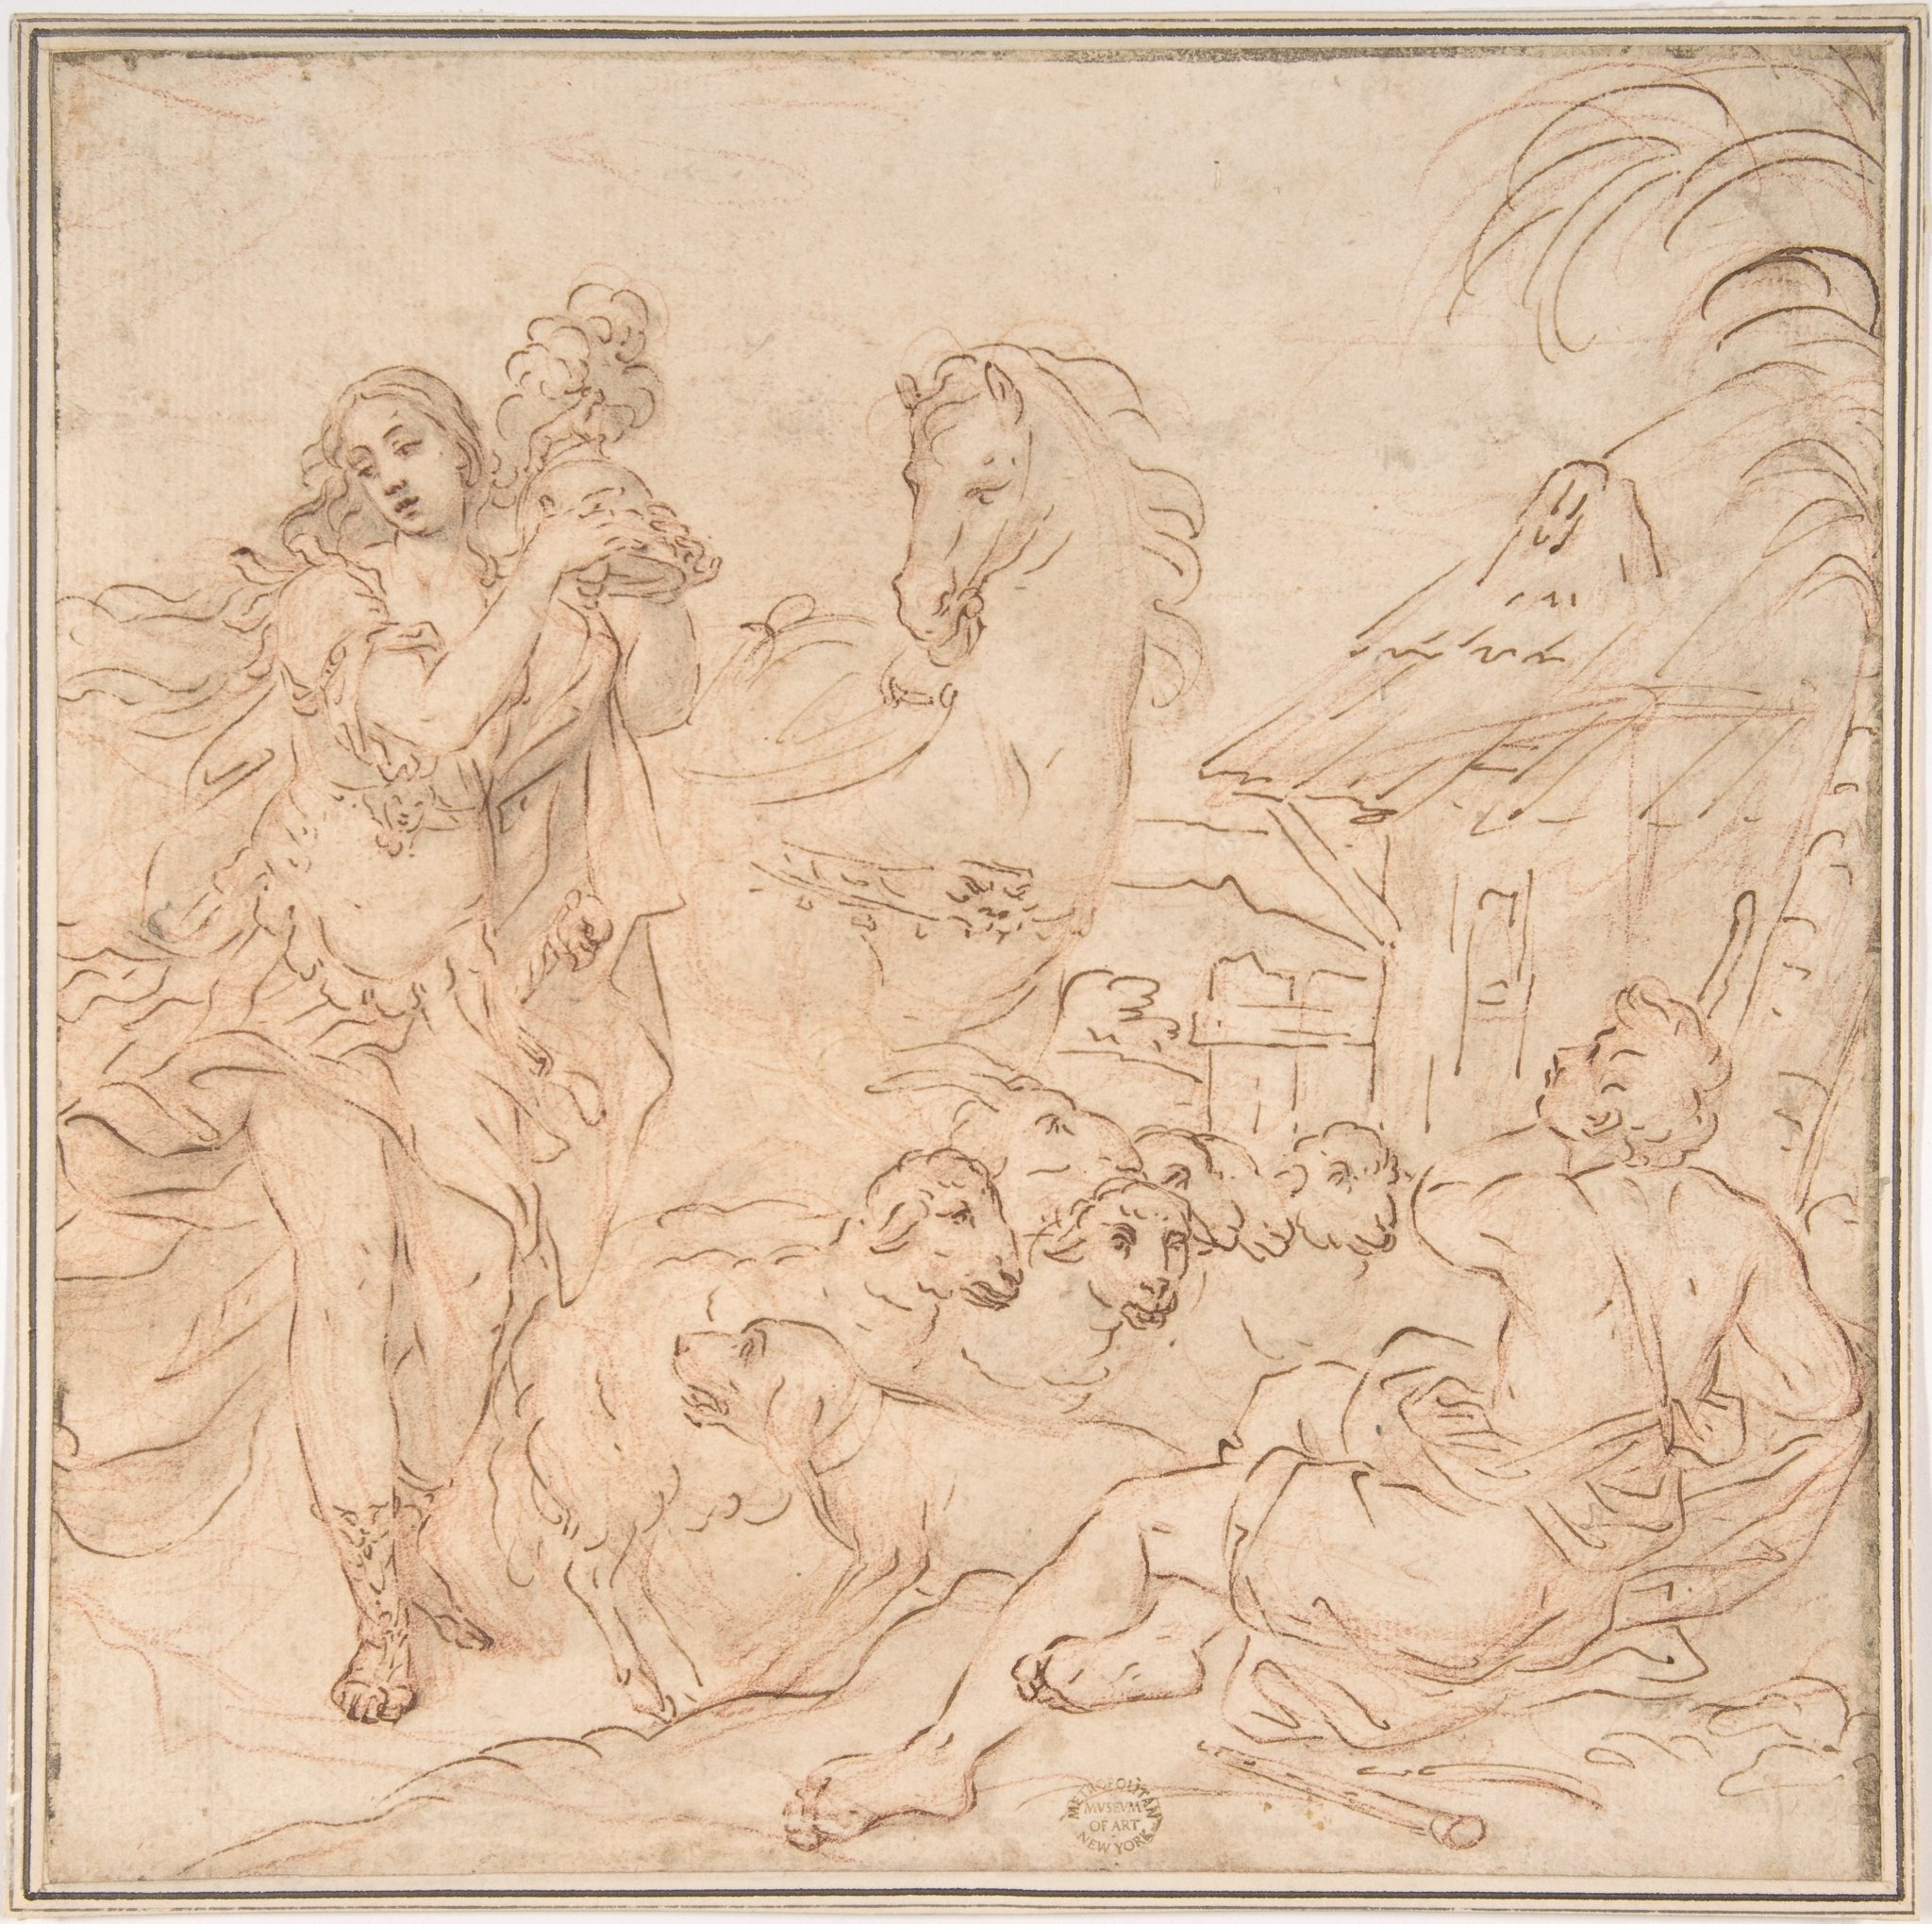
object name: drawing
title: Erminia and the Shepherds (a scene from Torquato Tasso's Gerusalemme Liberata)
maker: anonymous, italian, 17th century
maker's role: artist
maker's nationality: italian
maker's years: 1600-1700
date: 1650-1700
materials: chalk, ink, paper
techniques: brush, pen, wash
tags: women,dogs,horses,sheep,shepherds